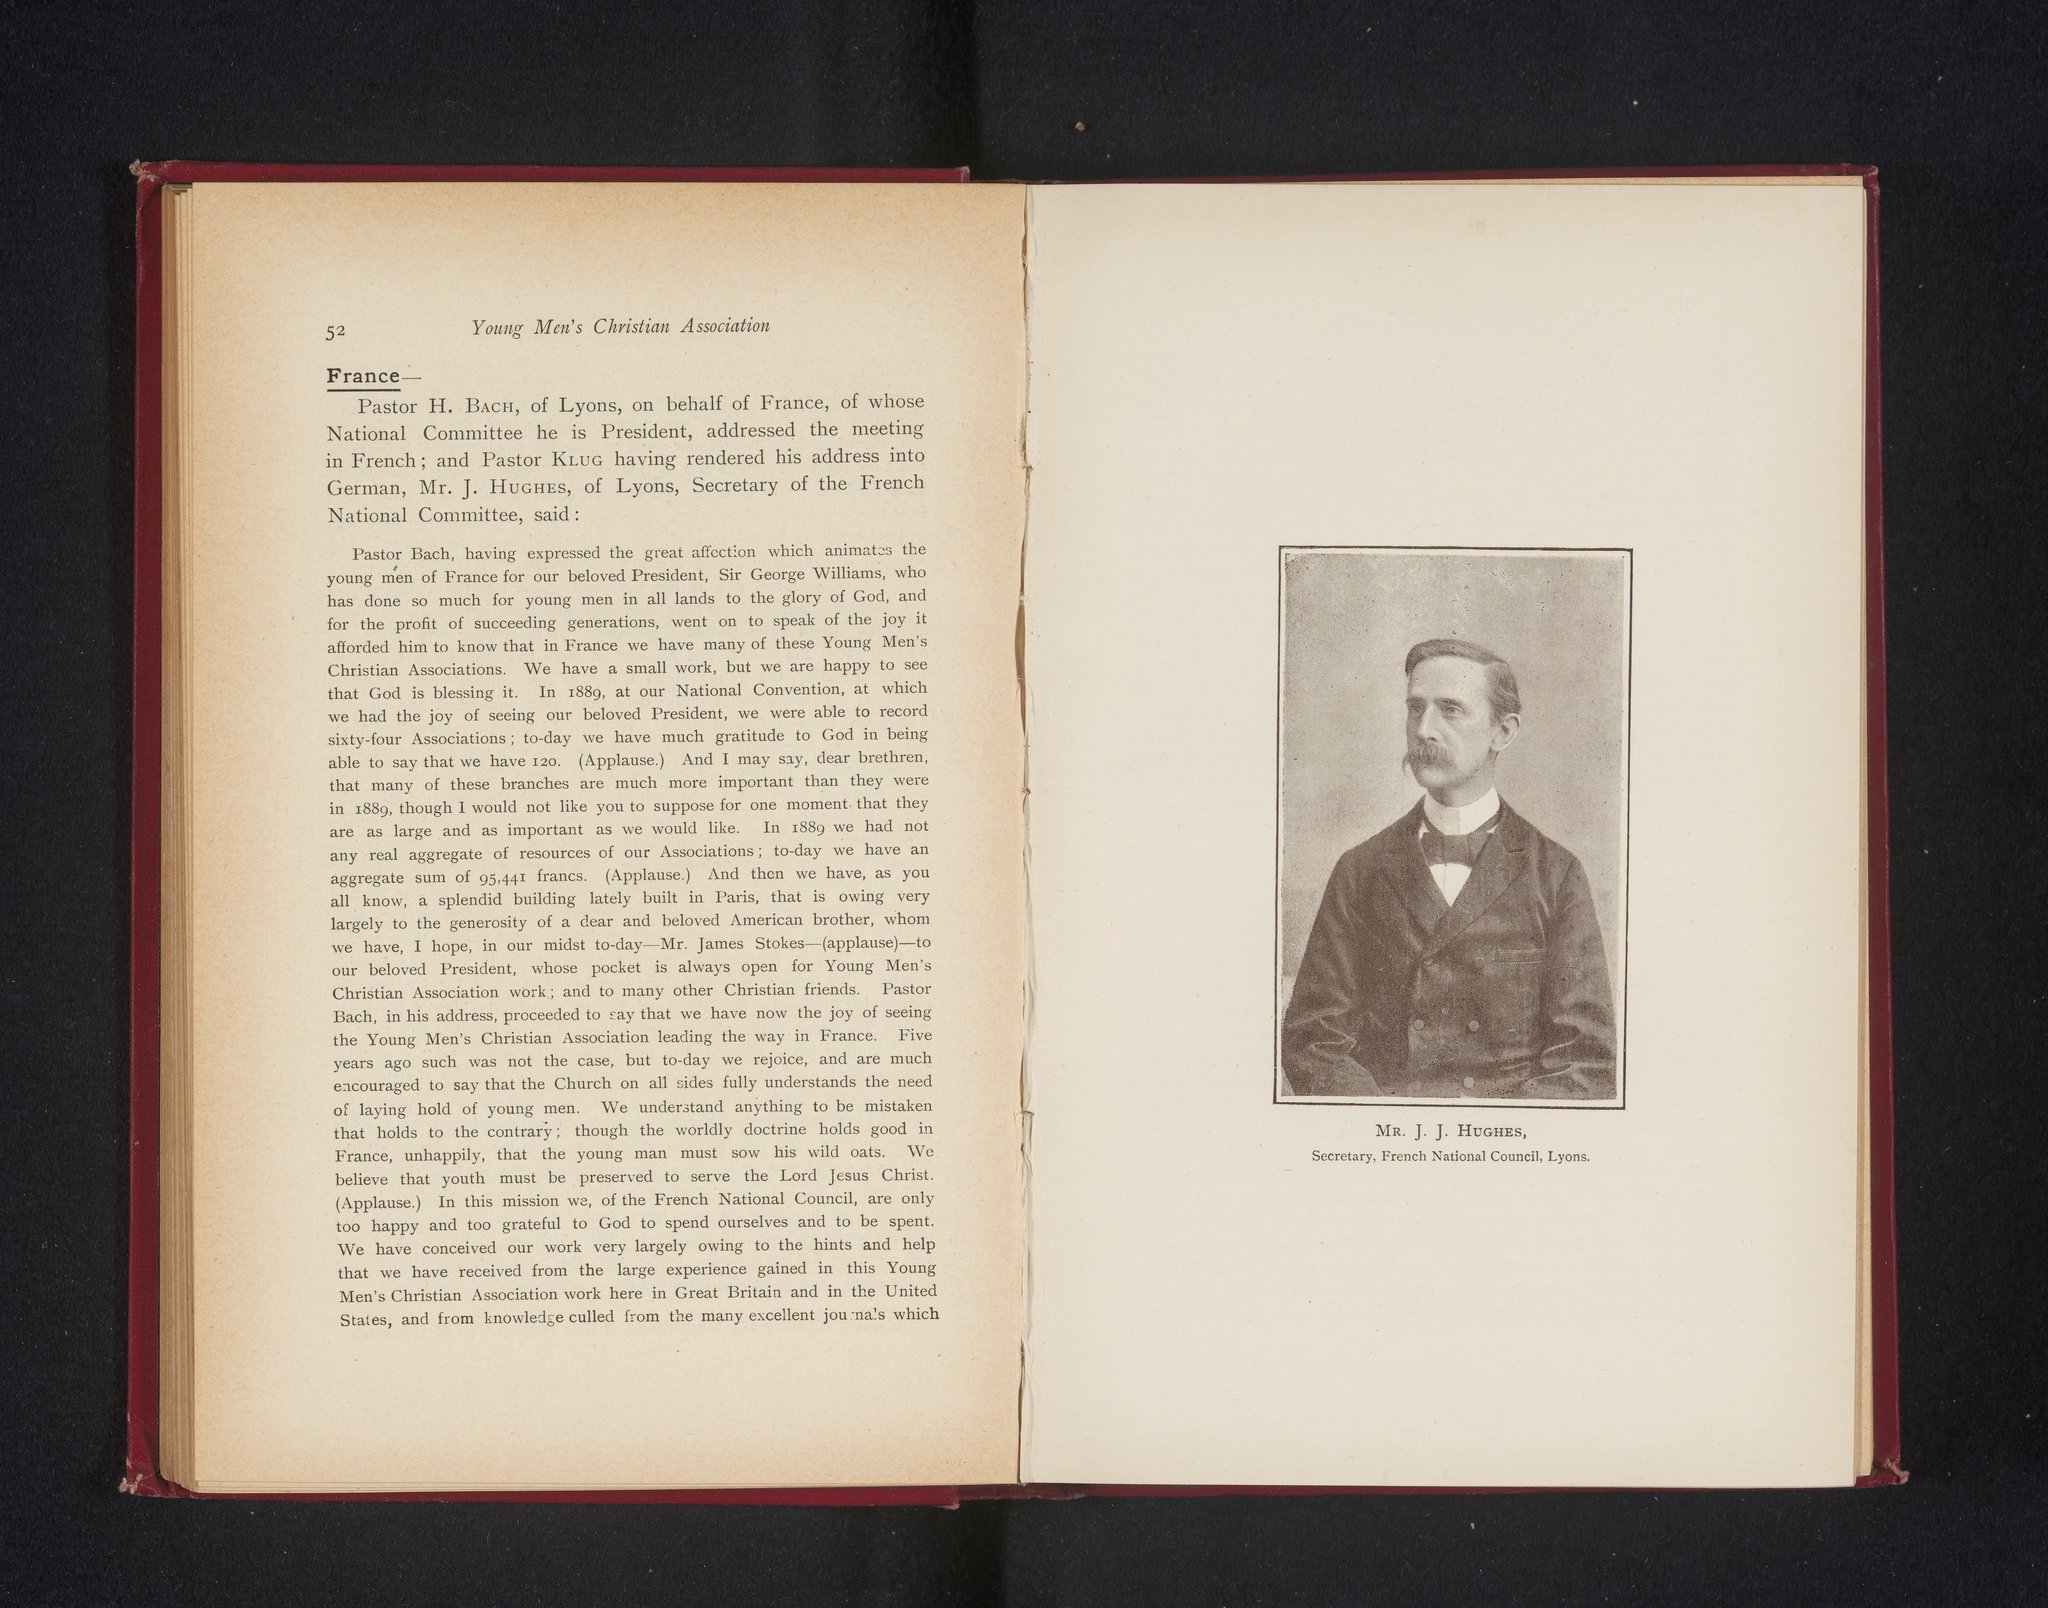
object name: page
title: Portret van J.J. Hughes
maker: Anonymous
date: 1890-1895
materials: paper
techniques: autotype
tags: historical persons